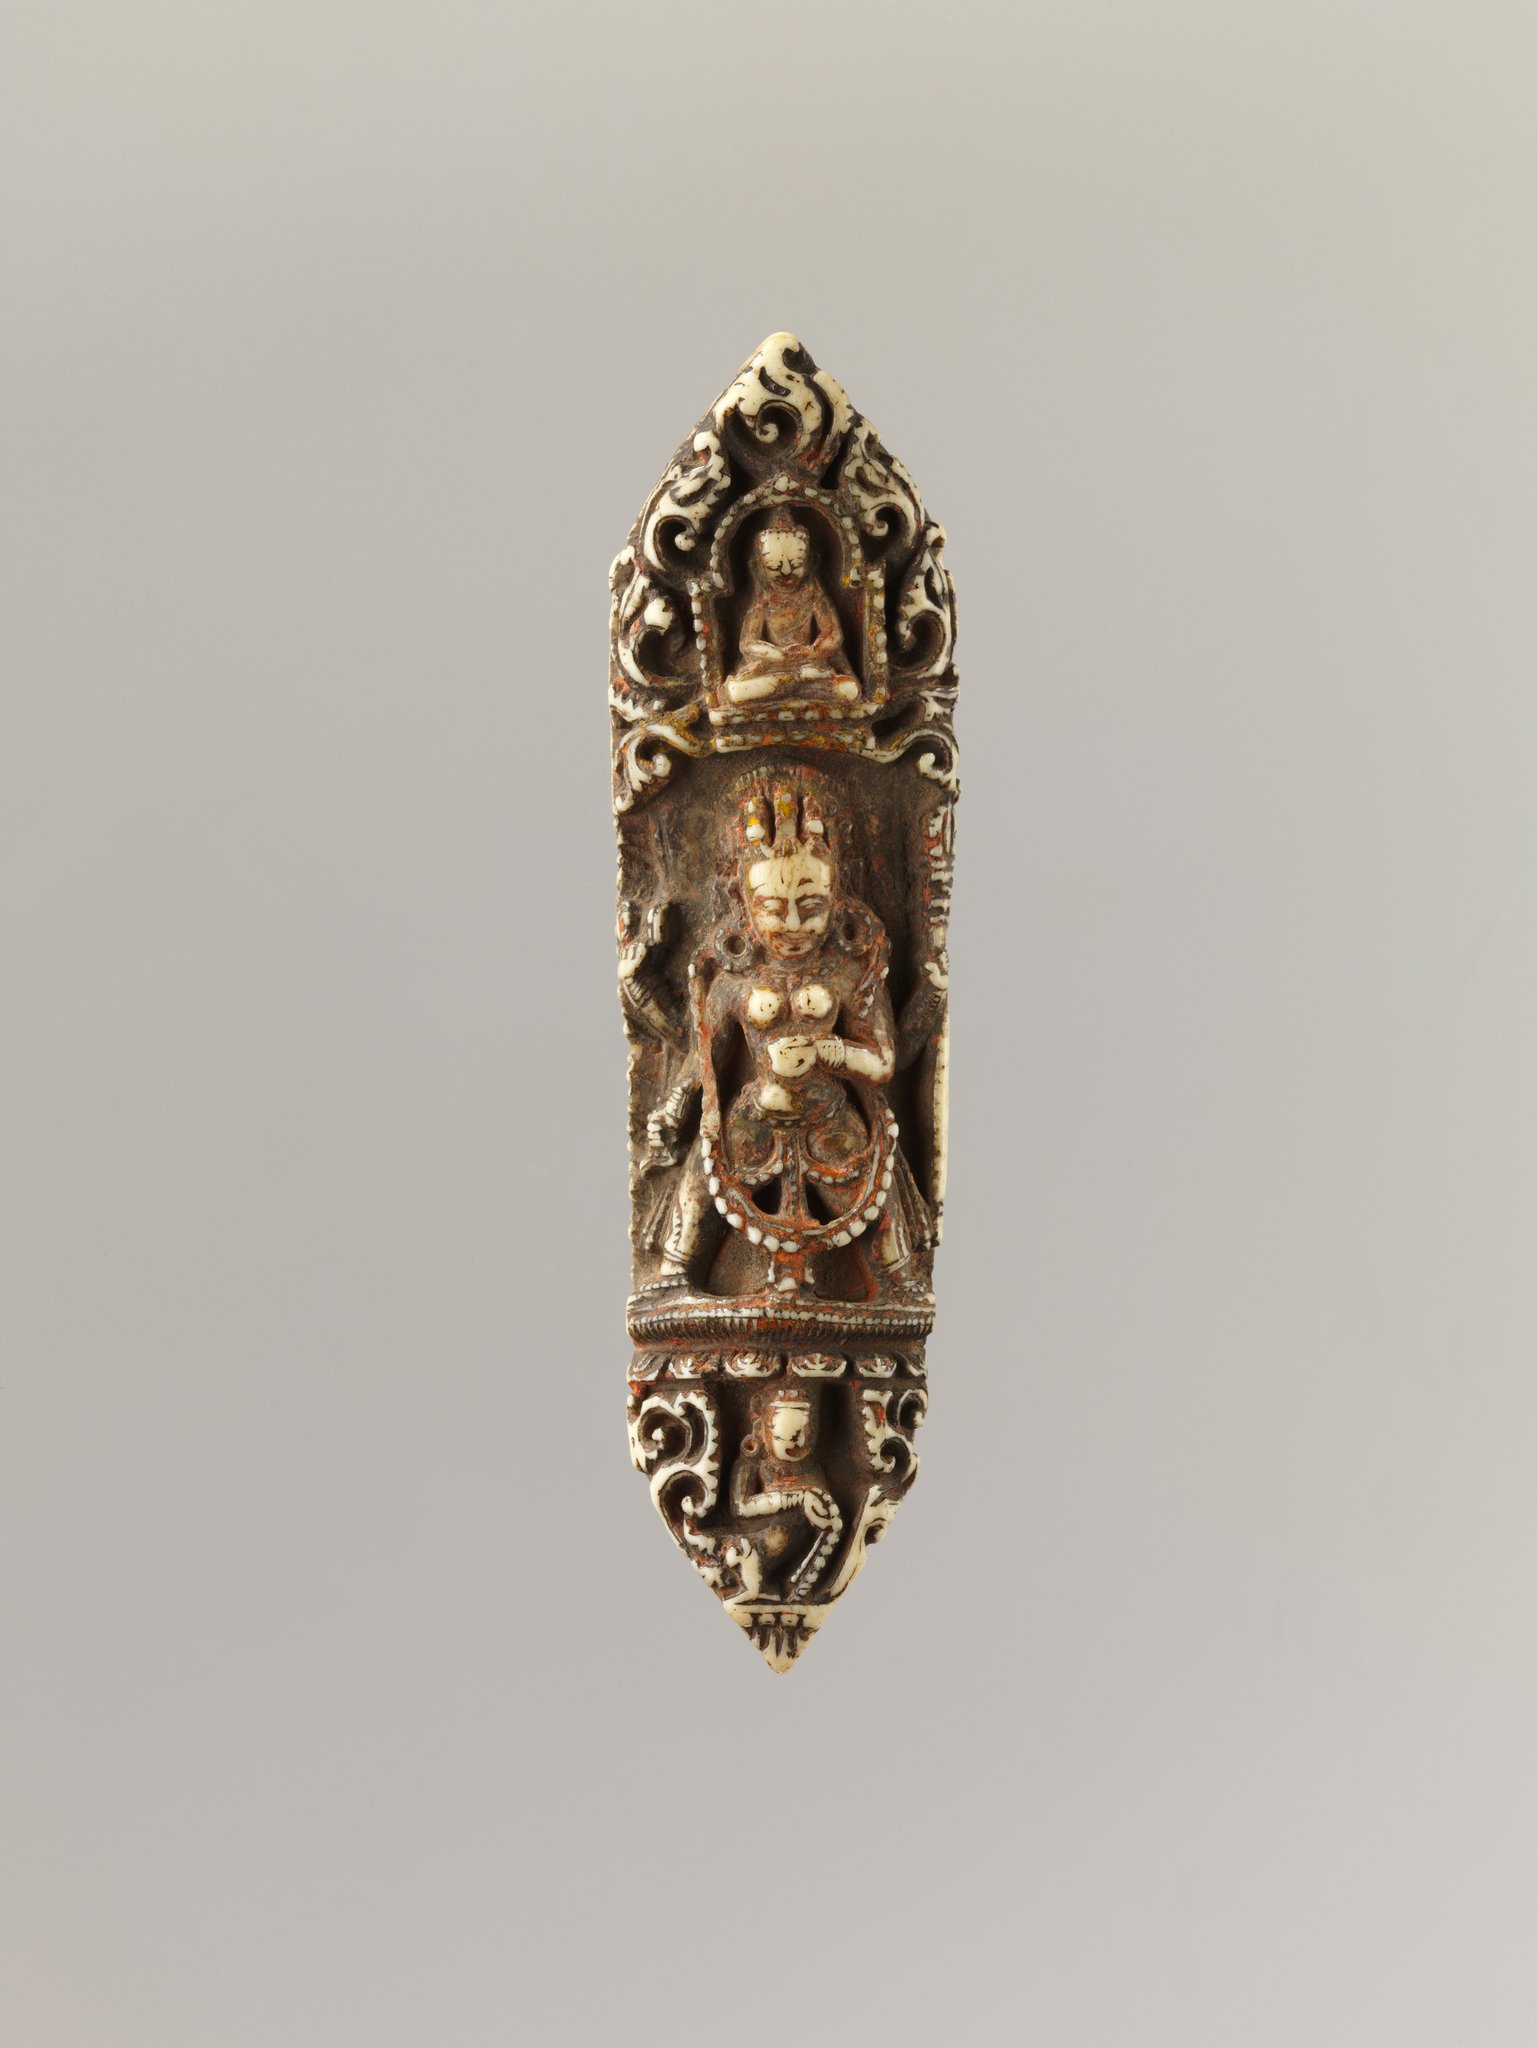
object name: plaque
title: Plaque from a Tantric Ritual Apron (Chakrasamvara and Vajravarahi at Center)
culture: nepali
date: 1501-1600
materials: bone